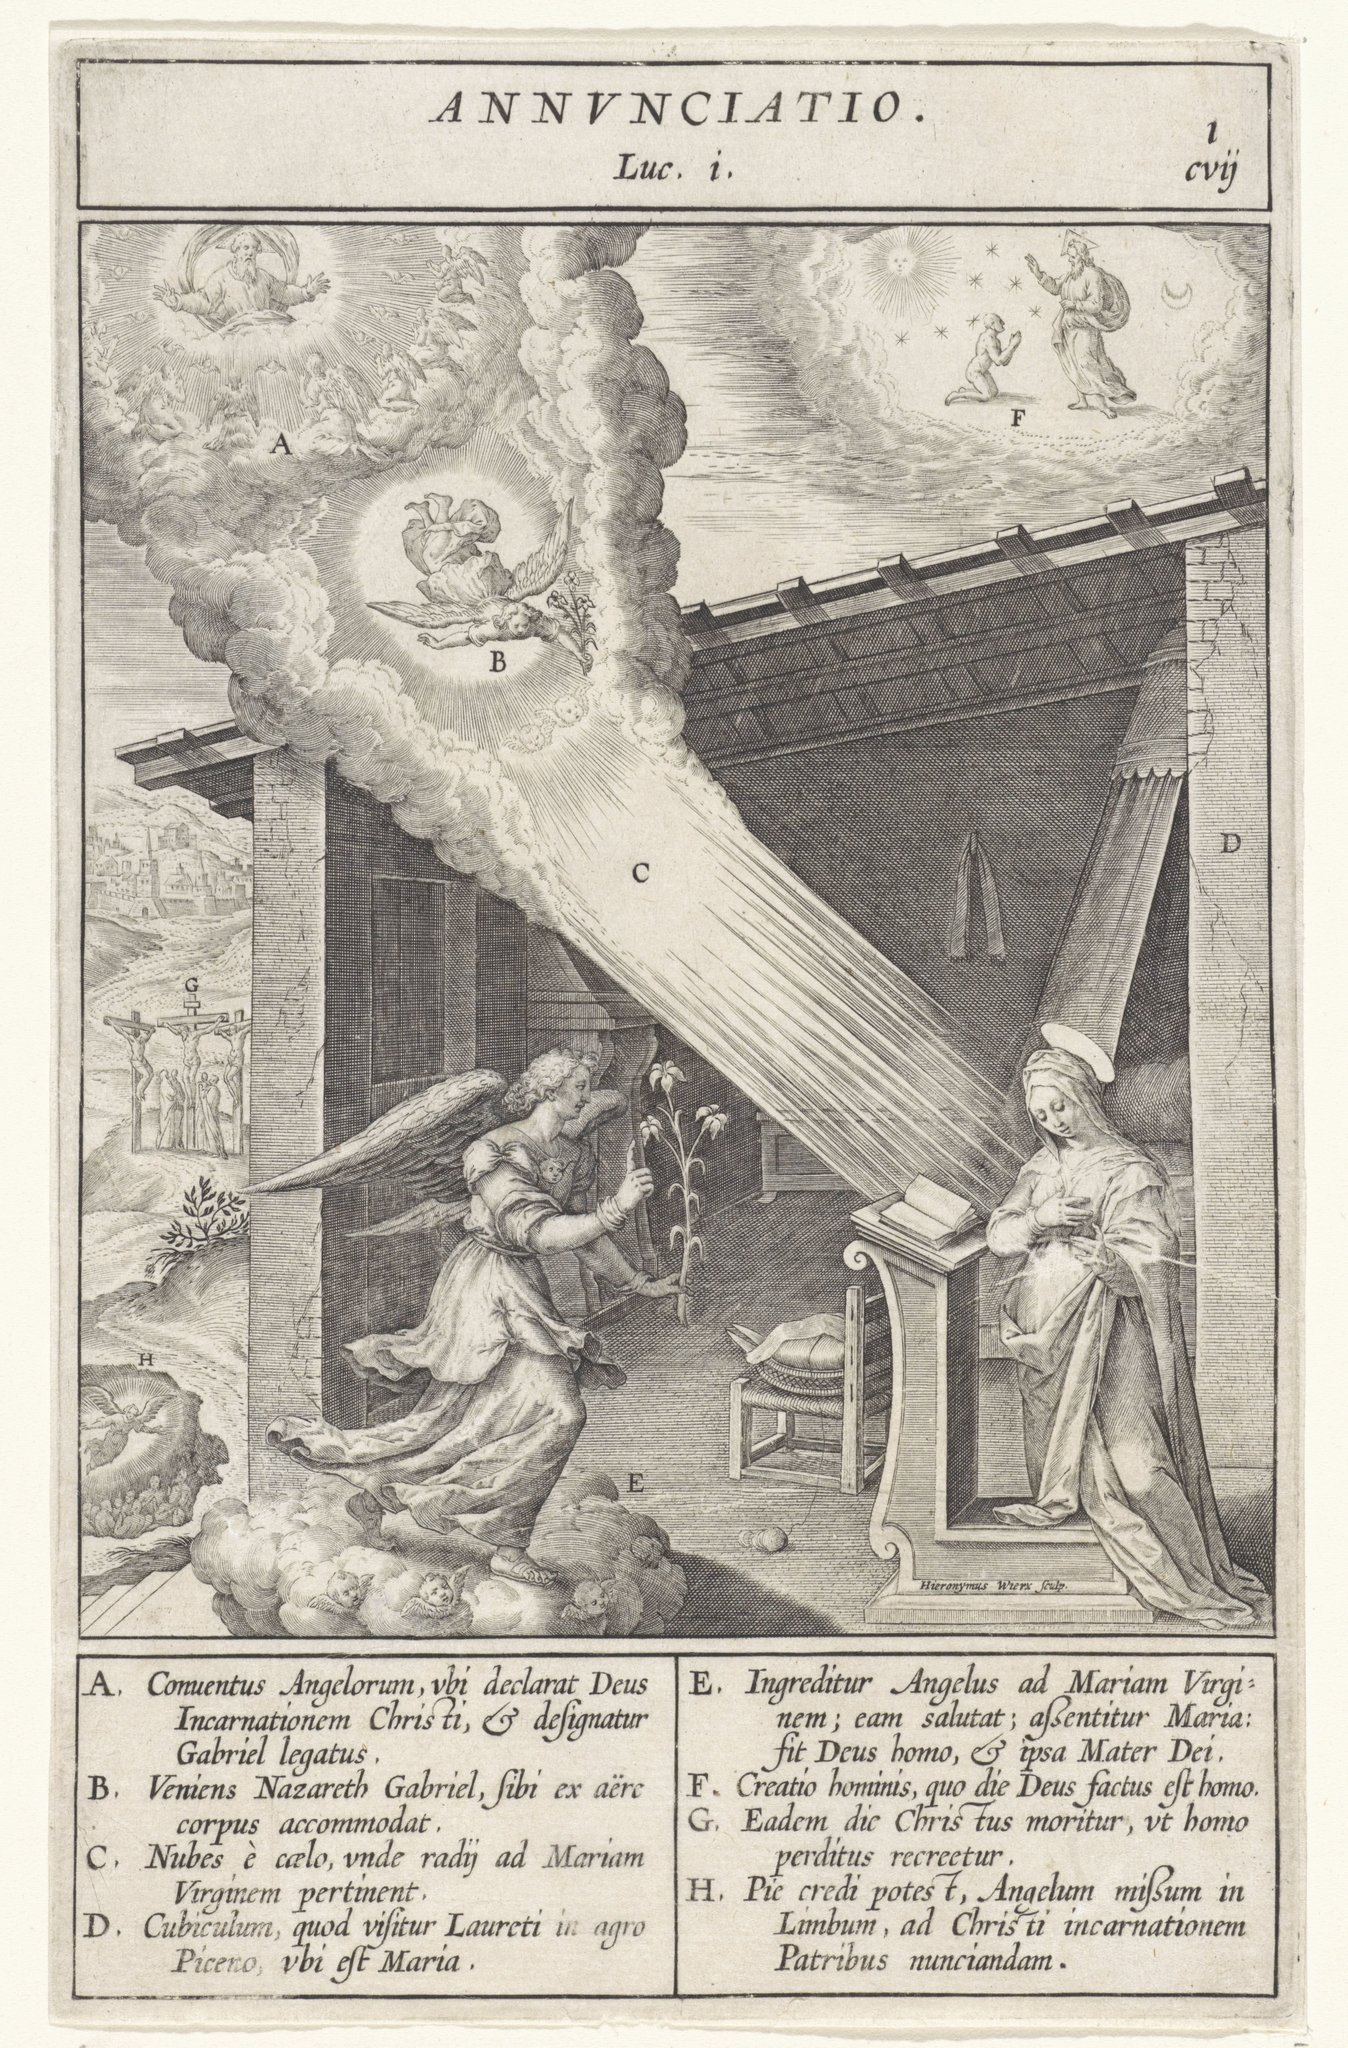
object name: print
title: Annvnciatio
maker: hieronymus wierix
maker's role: draughtsman, print maker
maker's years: 1553-1619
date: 1593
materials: paper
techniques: engraving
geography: antwerp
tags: god the father, the annunciation: mary, usually reading, is visited by the angel (sometimes a woman overhears the conversation), the crucifixion of christ: christ's death on the cross; golgotha (matthew 27:45-58; mark 15:33-45; luke 23:44-52; john 19:25-38)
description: Maria aan haar lessenaar in haar slaapvertrek. Ze wordt bezocht door de engel Gabriël. Hij vertelt haar dat ze een zoon zal baren die Christus zal heten. Vanuit de hemel daalt een engel met een lelie neer. Op de achtergrond de kruisiging van Christus. Bij verschillende elementen uit de voorstelling staan letters die corresponderen met de legenda in de marge.